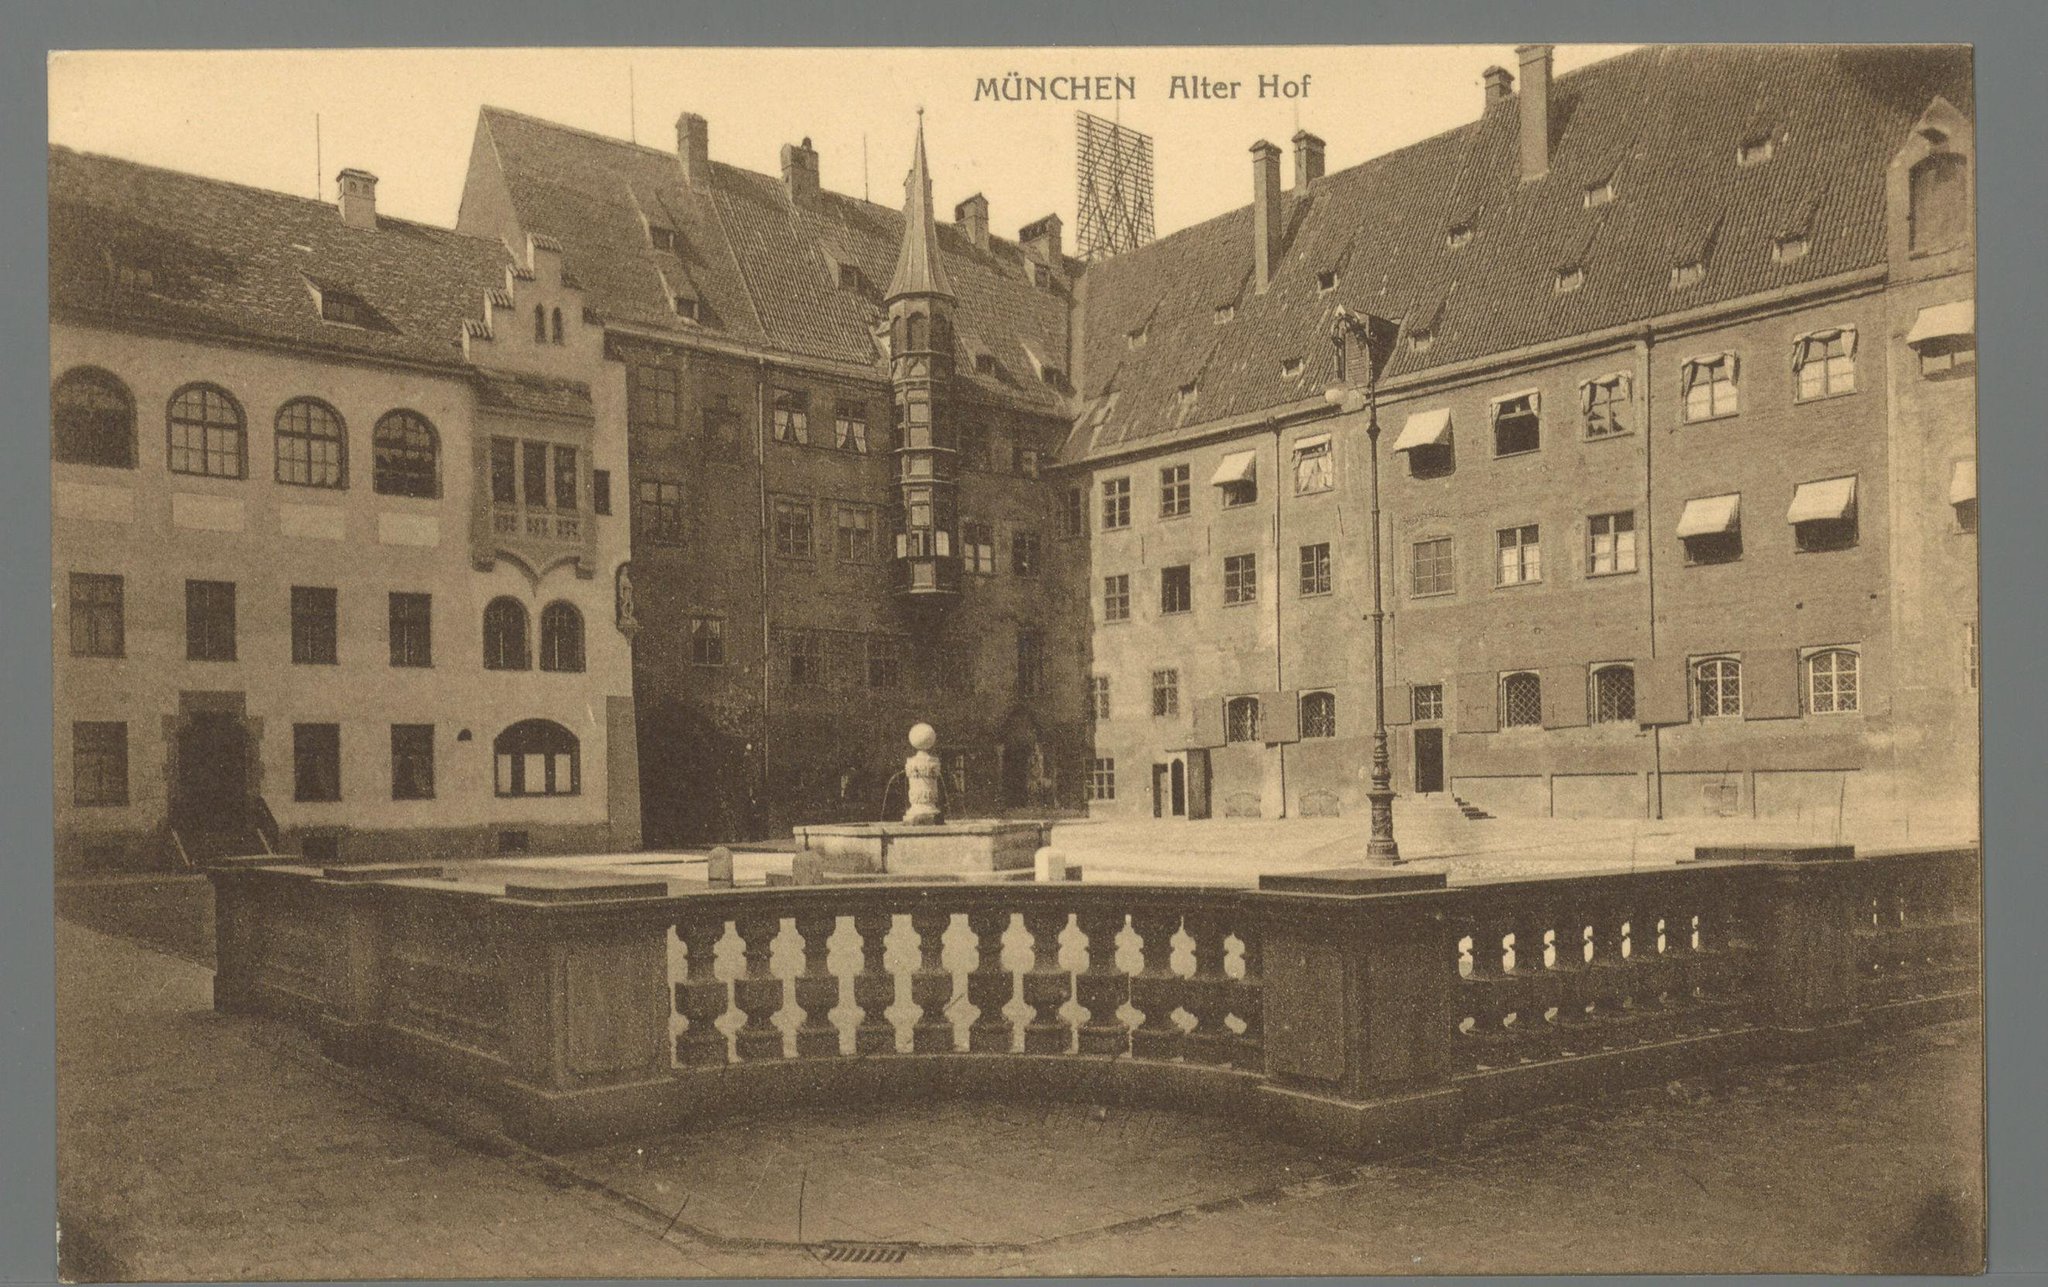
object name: photomechanical print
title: München. Alter Hof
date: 1905-1930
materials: cardboard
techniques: photograph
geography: munich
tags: palace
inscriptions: inscription: ‘W.H.D.’